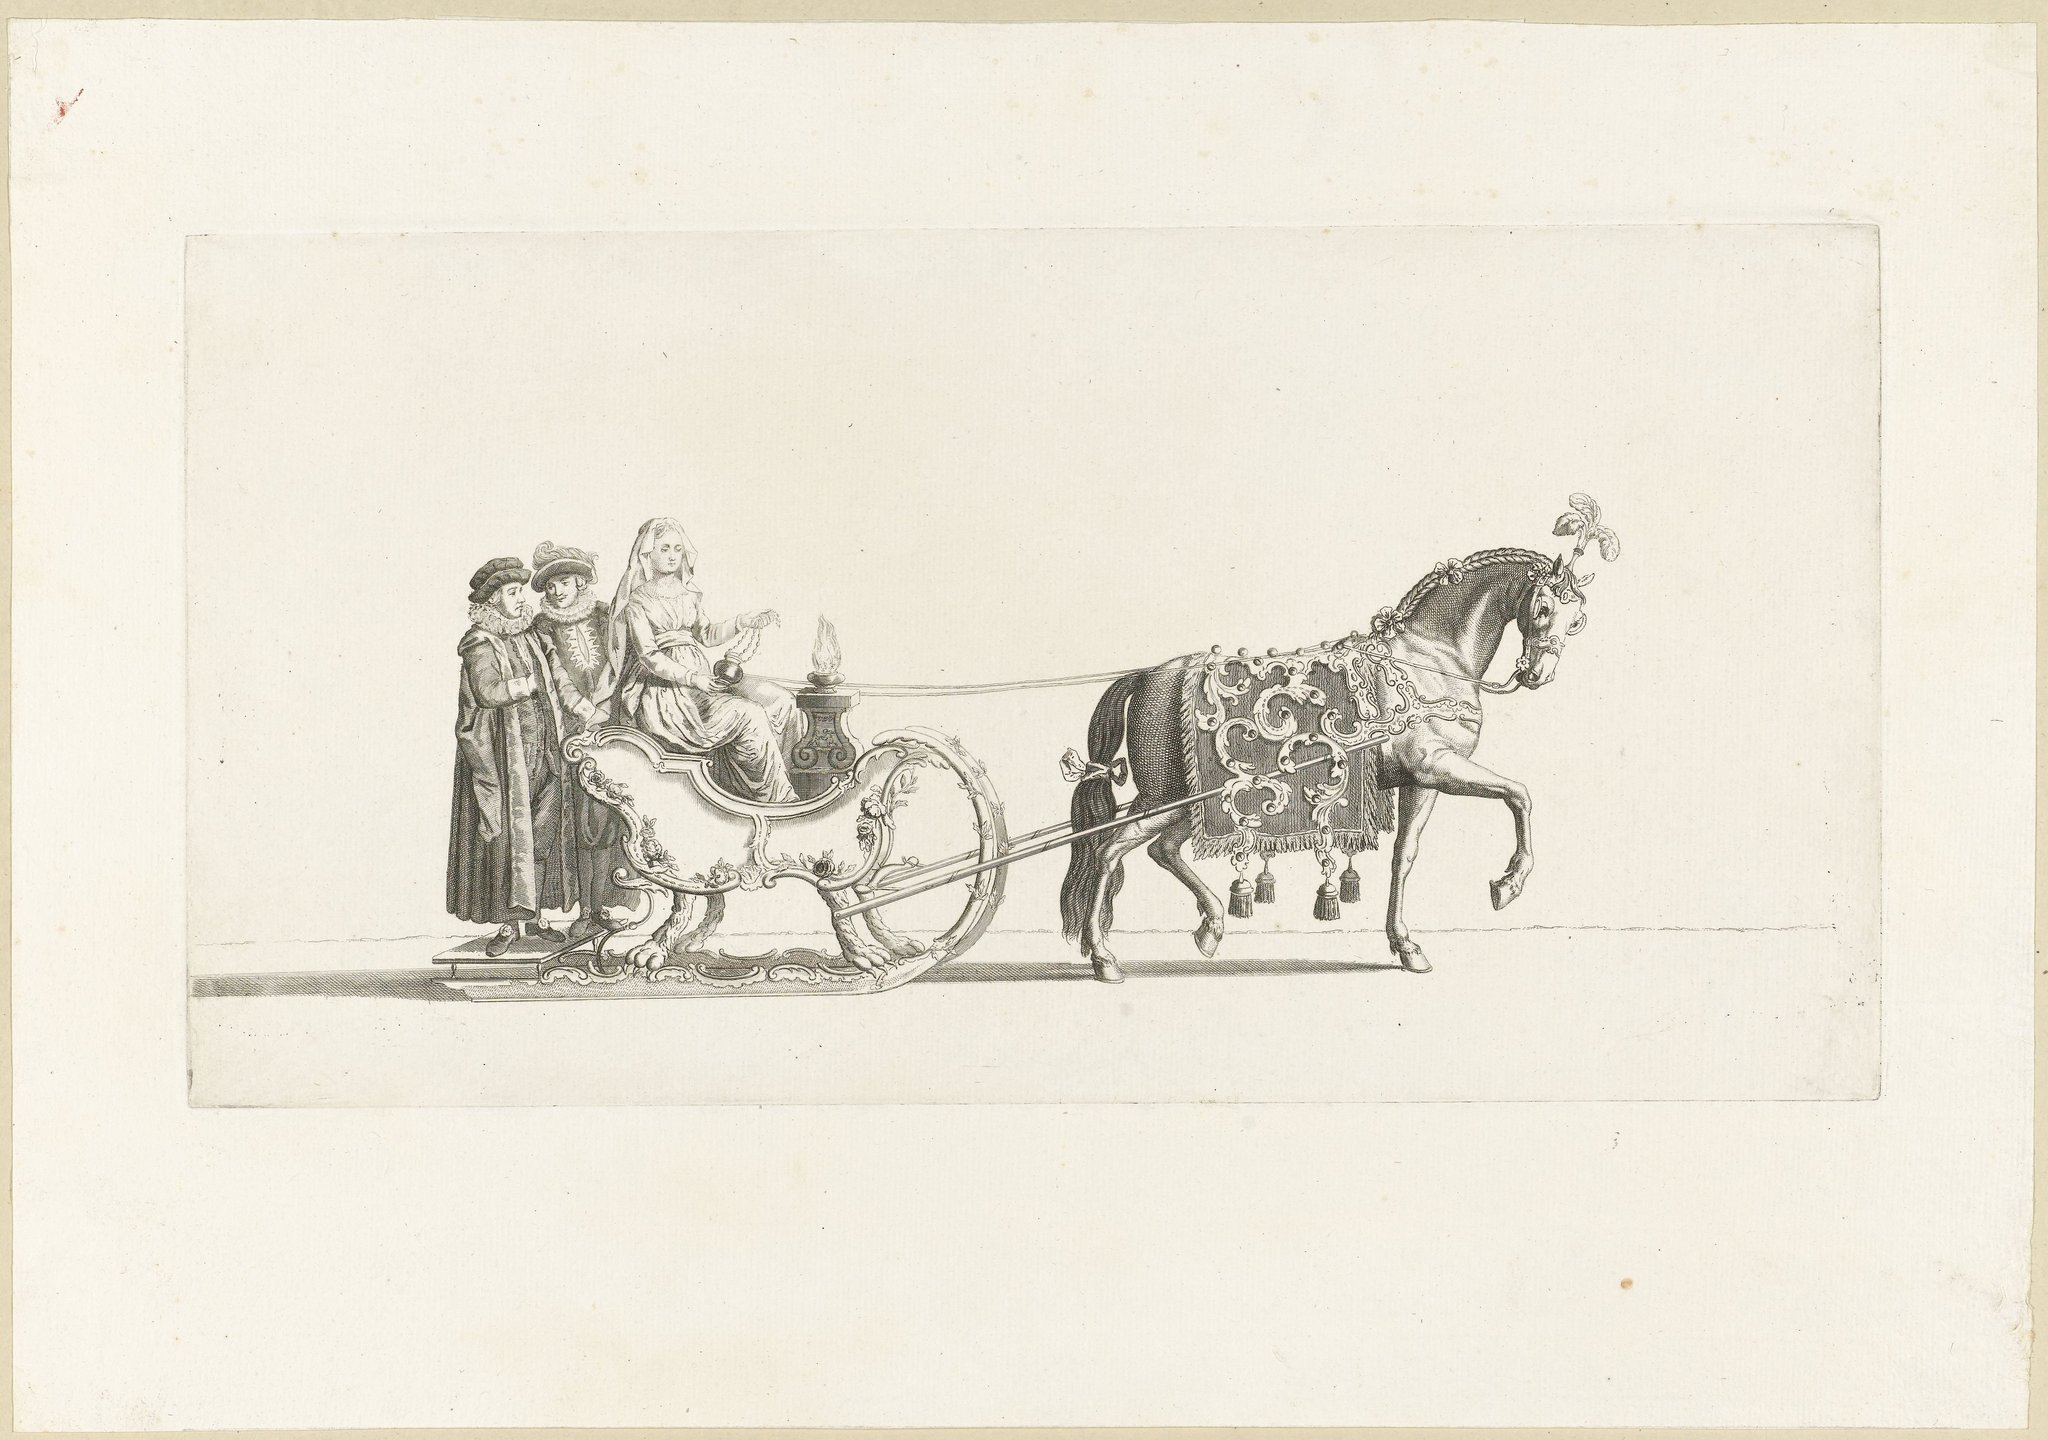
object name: print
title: Achtste slede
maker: nicolaas van der worm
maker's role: draughtsman, print maker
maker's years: 1757-1828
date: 1776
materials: paper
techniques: engraving, etching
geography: northern netherlands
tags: allegorical representations ~ religion; 'religione', 'religione de ss. mauritio e lazaro', 'religione vera christiana' (ripa), sledge, sleigh (winter sports), commemoration of the founding of a university, leiden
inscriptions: collector's mark: Lugt 240, inscription: ‘afgemaekte Proefdruk / N vd worm’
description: De achtste slede in de optocht. Een slede met de personificatie van de Godsdienst, getrokken door een paard. Onderdeel van een reeks van twaalf platen (vóór het nummer en op ander papier) van de sledevaart op 24 januari 1776 georganiseerd door het Leidse genootschap Veniam Pro Laude bij gelegenheid van het Tweede Eeuwfeest van het Leids Ontzet (3 oktober 1574) en de oprichting van de Universiteit van Leiden (8 februari 1575).